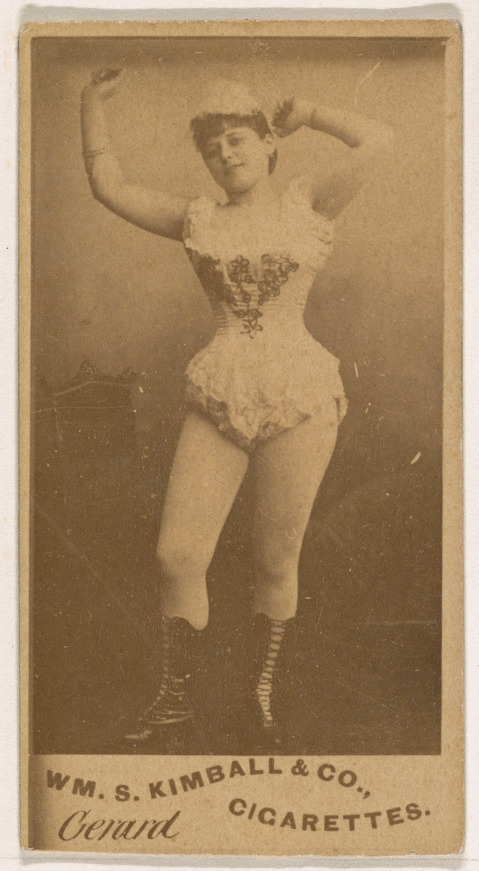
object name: photograph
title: Miss Gerard, from the Actresses series (N203) issued by Wm. S. Kimball & Co.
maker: william s. kimball & company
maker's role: publisher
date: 1889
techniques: color lithograph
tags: portraits,women,actresses